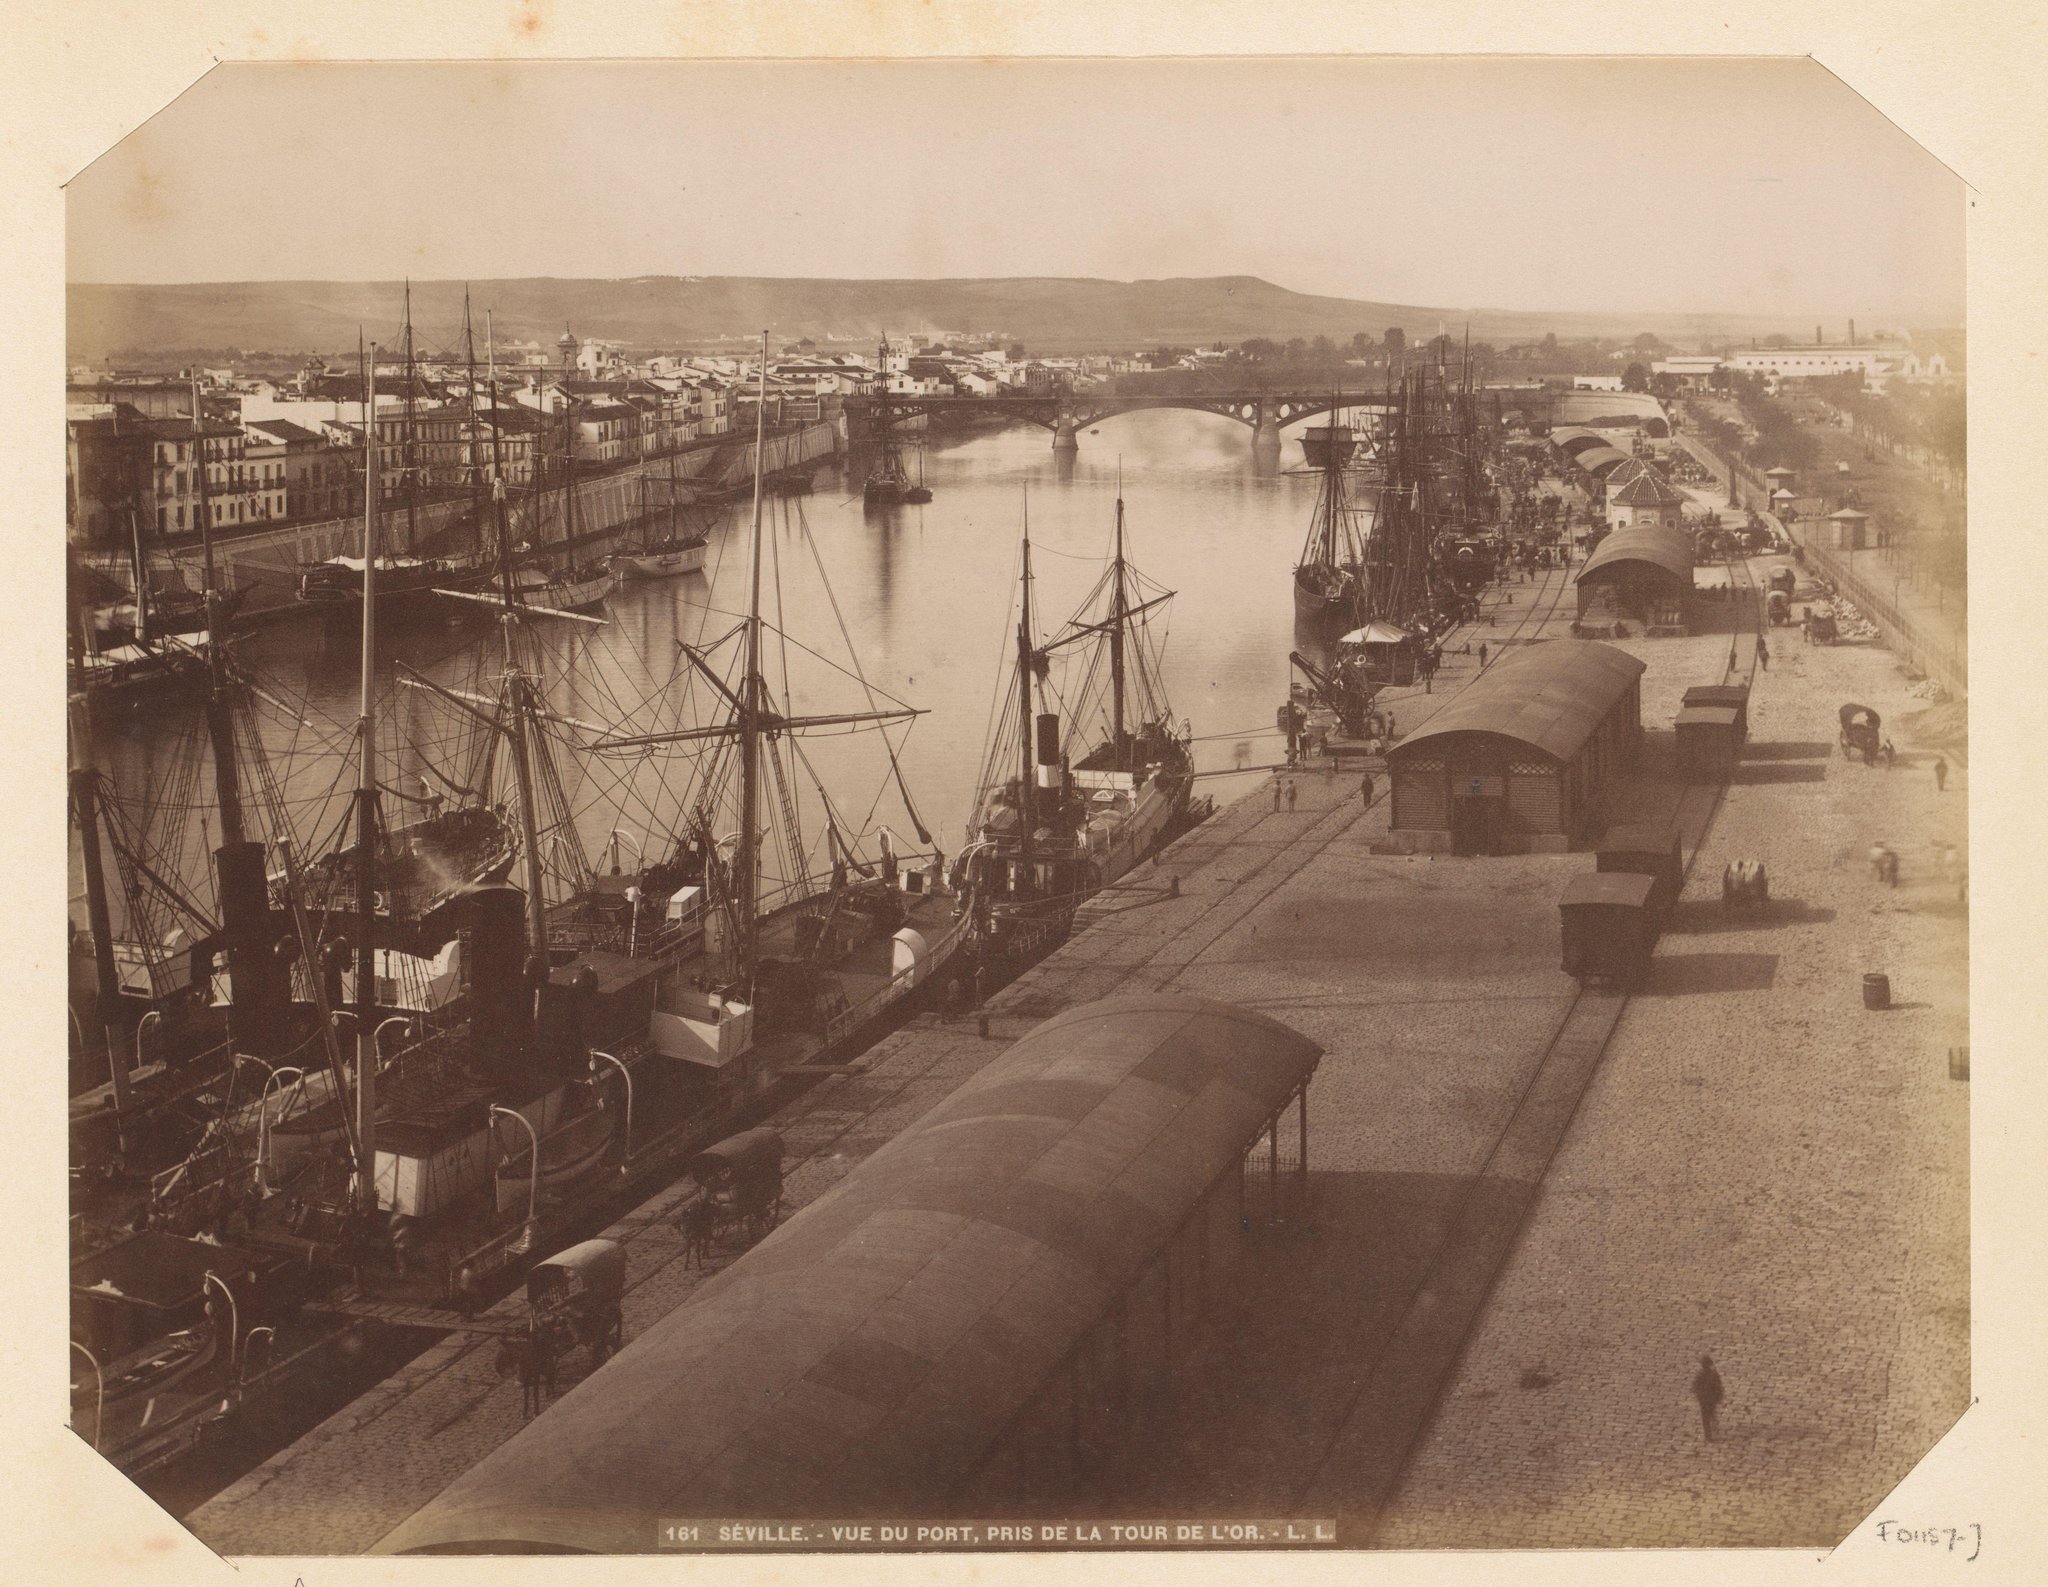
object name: album leaf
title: Gezicht op de haven van Sevilla vanaf de Torre del Oro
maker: ll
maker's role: fotograaf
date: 1885-1892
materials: photographic support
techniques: albumen print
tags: harbour, ships (in general), bridge, sevilla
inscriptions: annotation: ‘Sevilla - Haven’, number: ‘161’